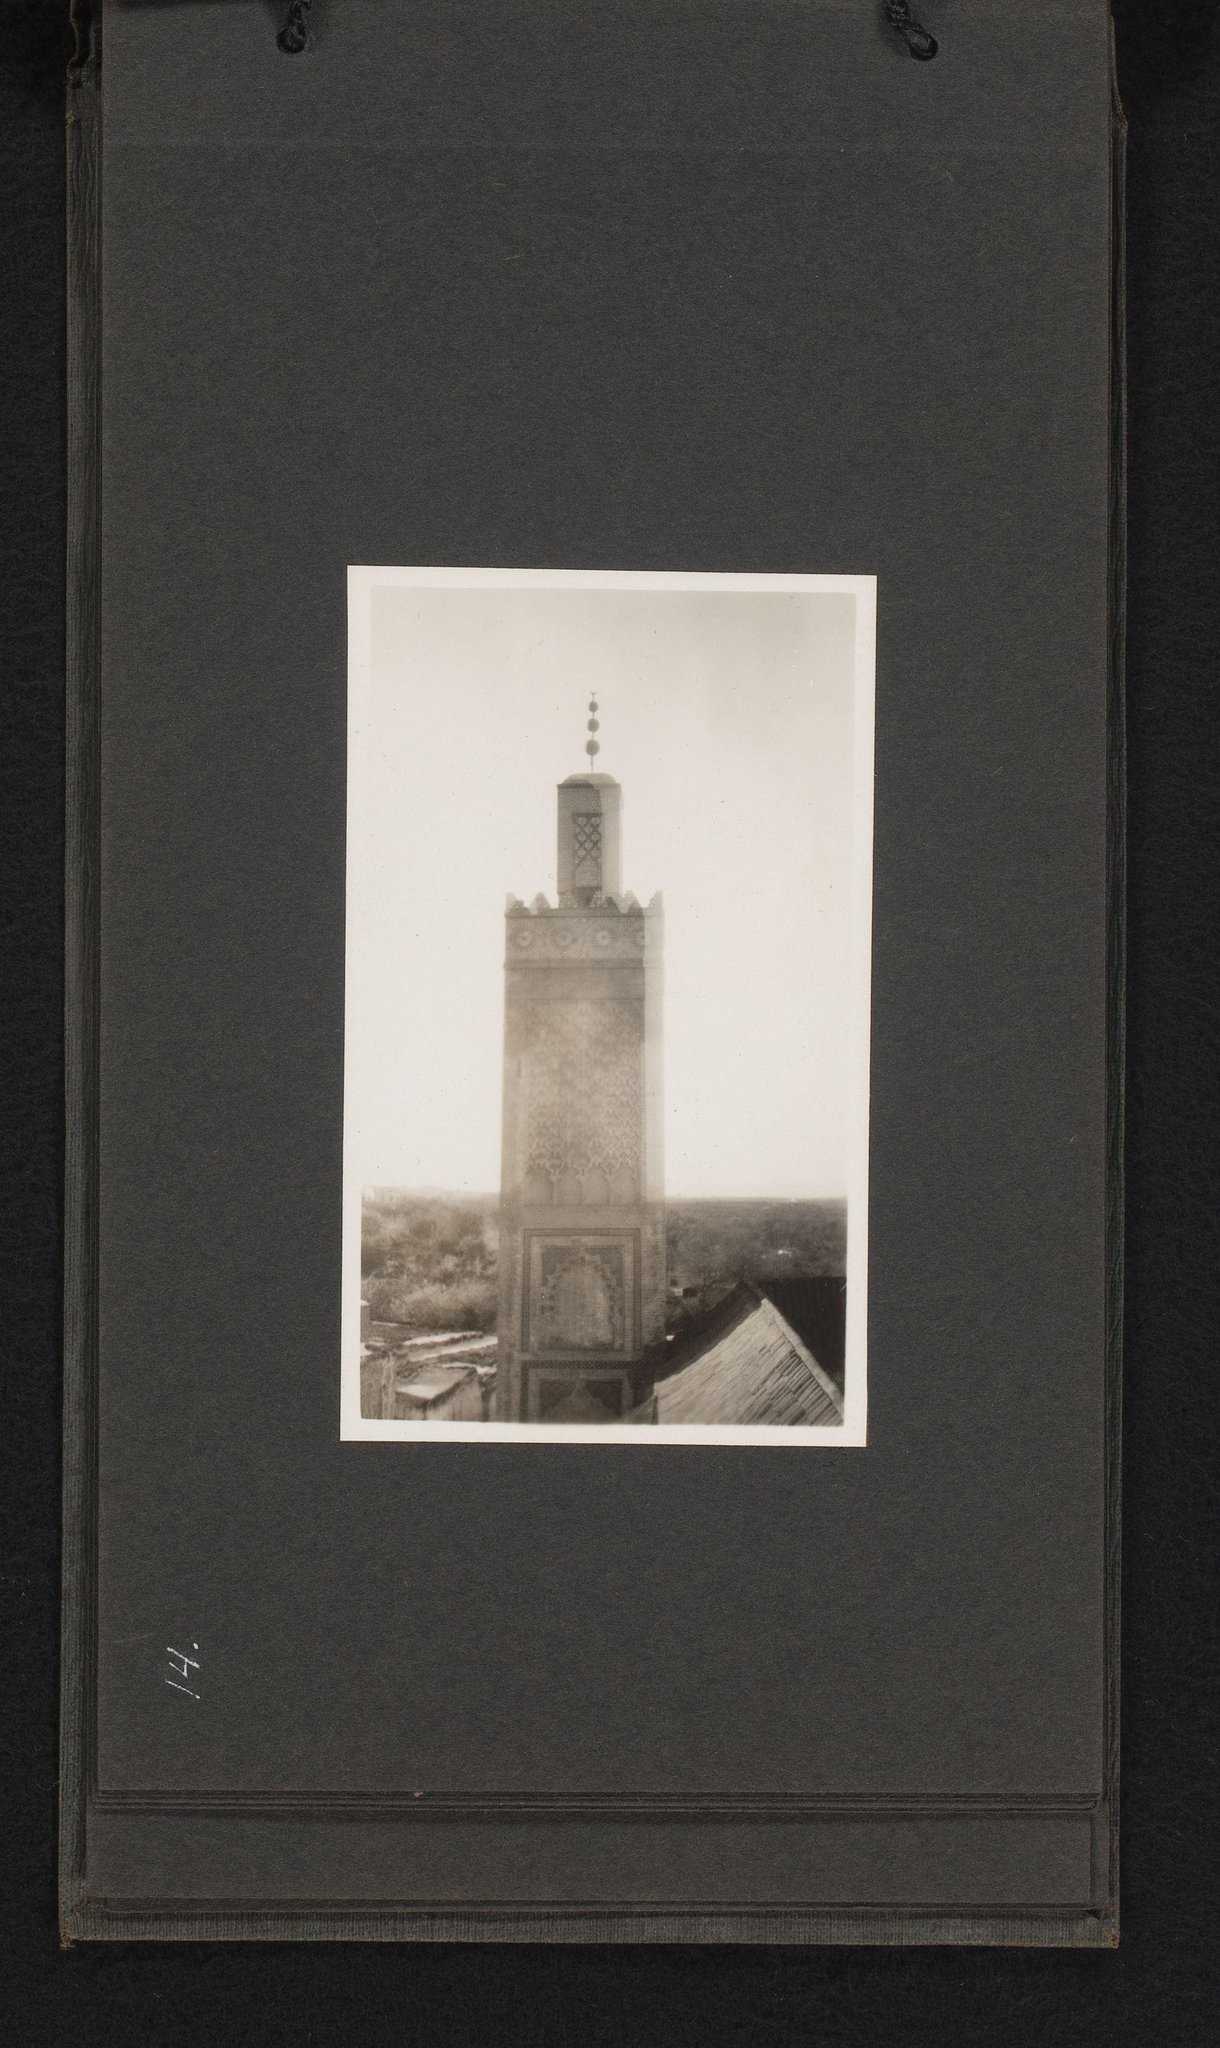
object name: photograph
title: Toren der moskee van Sidi El Haloei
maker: a.g.a. van eelde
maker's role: engineer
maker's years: 1862-1950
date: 1927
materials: paper, photographic support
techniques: gelatin silver print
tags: temple, shrine ~ islam, mohammedanism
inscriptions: number: ‘14.’